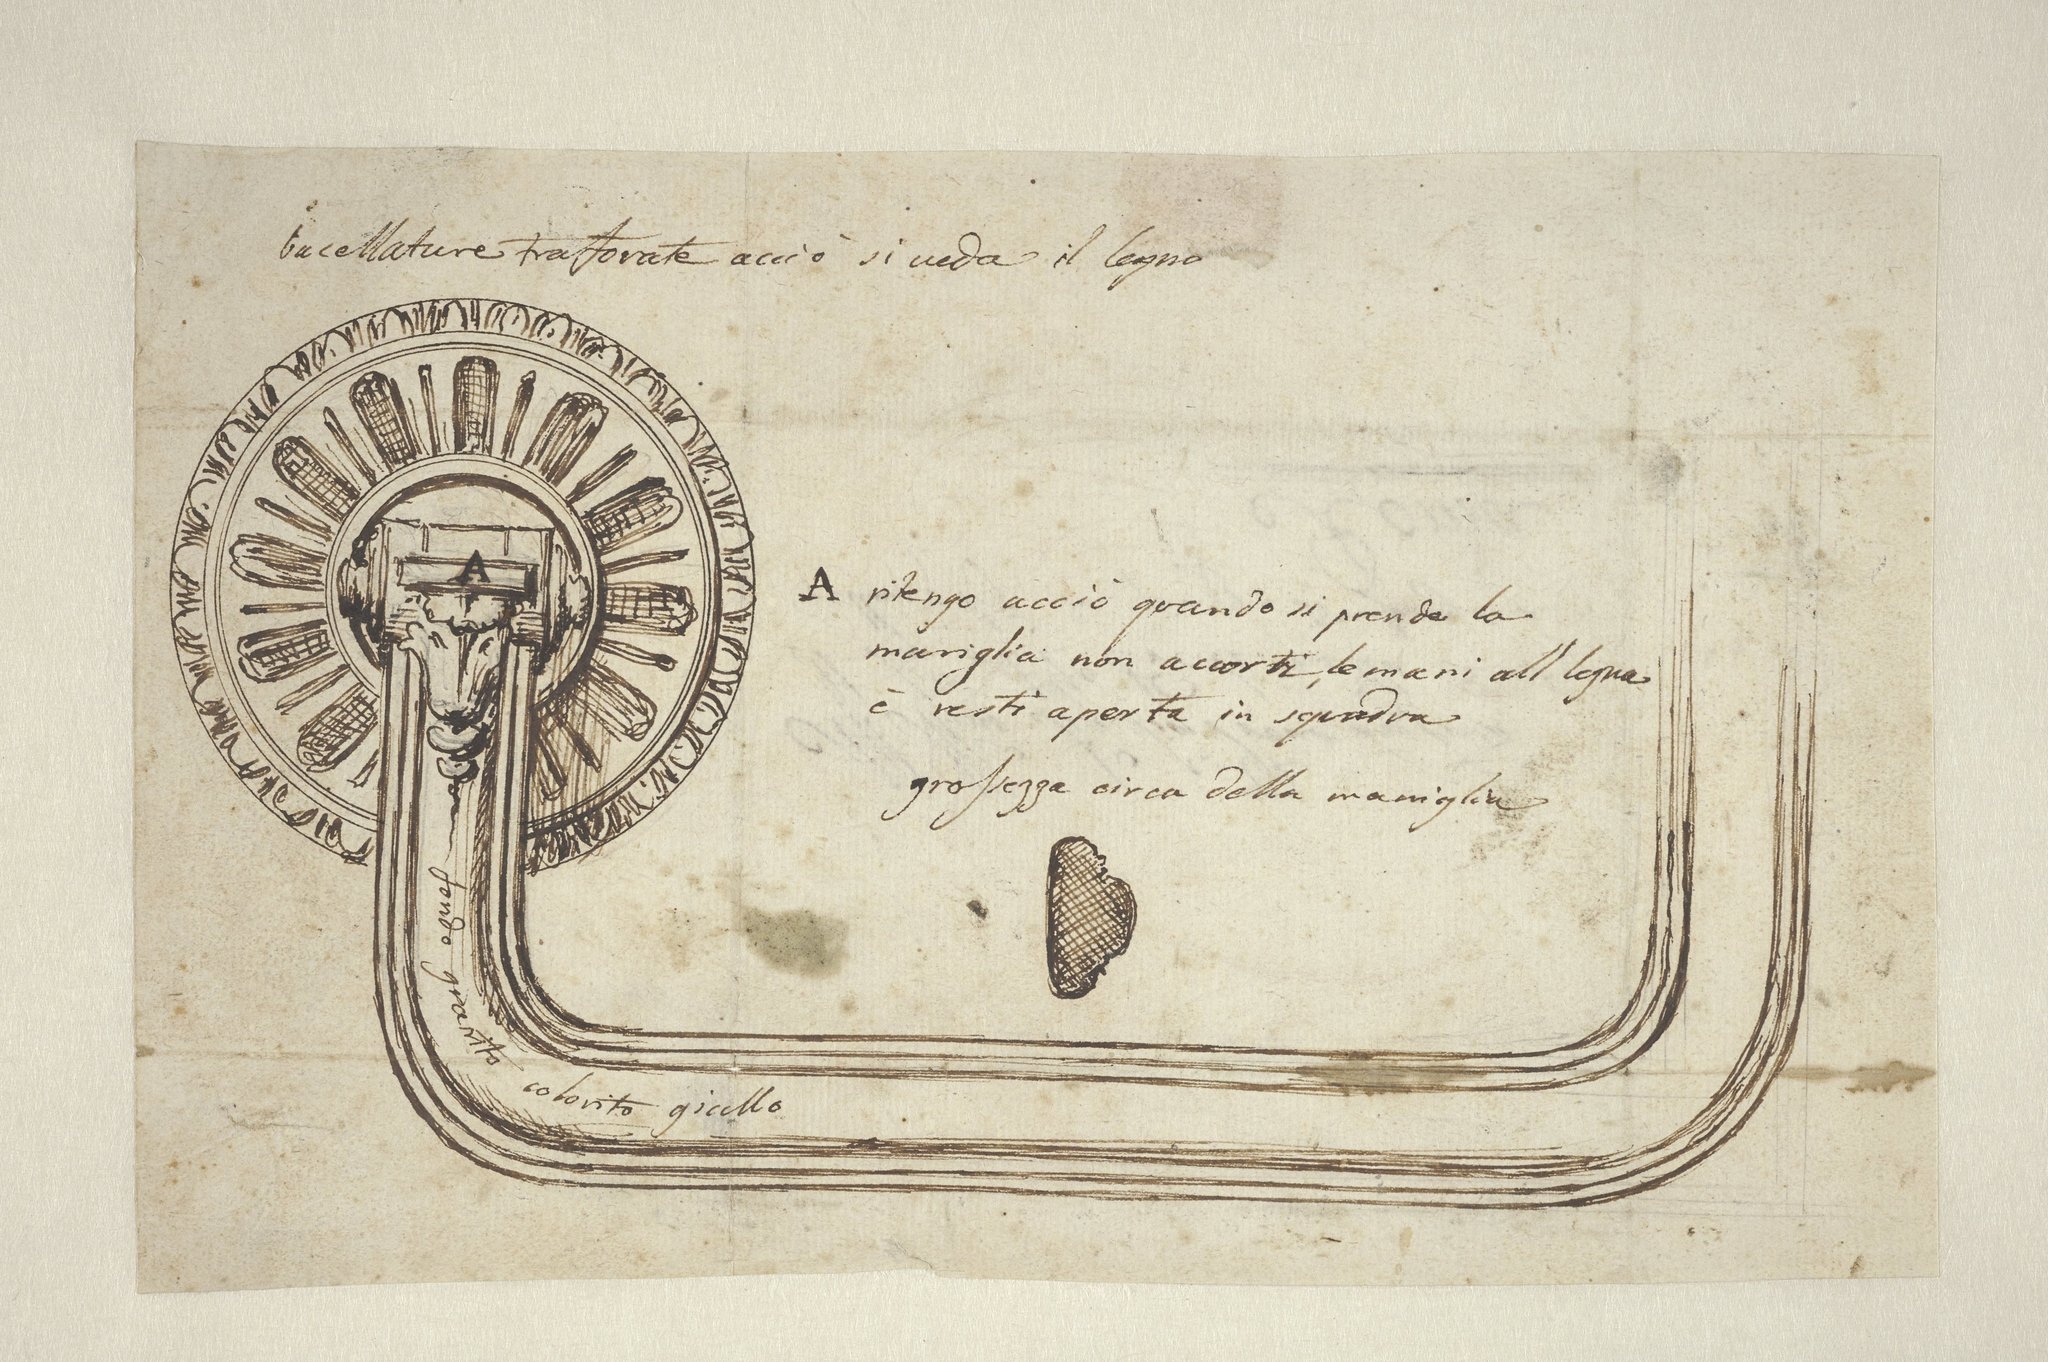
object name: drawing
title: Ontwerp voor een hengsel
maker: luigi valadier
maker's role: draughtsman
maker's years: 1726-1785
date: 1784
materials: ink, paper, pencil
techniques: pen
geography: italy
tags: decorative furniture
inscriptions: inscription, inscription: ‘All Illmo Sig Sig Prove Latino / Il Sig Anto Ercoli nella Bottega / della Arg in piazza di Spagna / Roma’